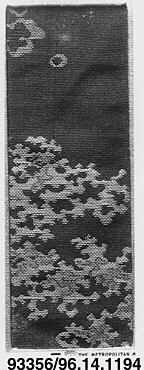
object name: piece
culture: japanese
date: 1701-1900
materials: silk